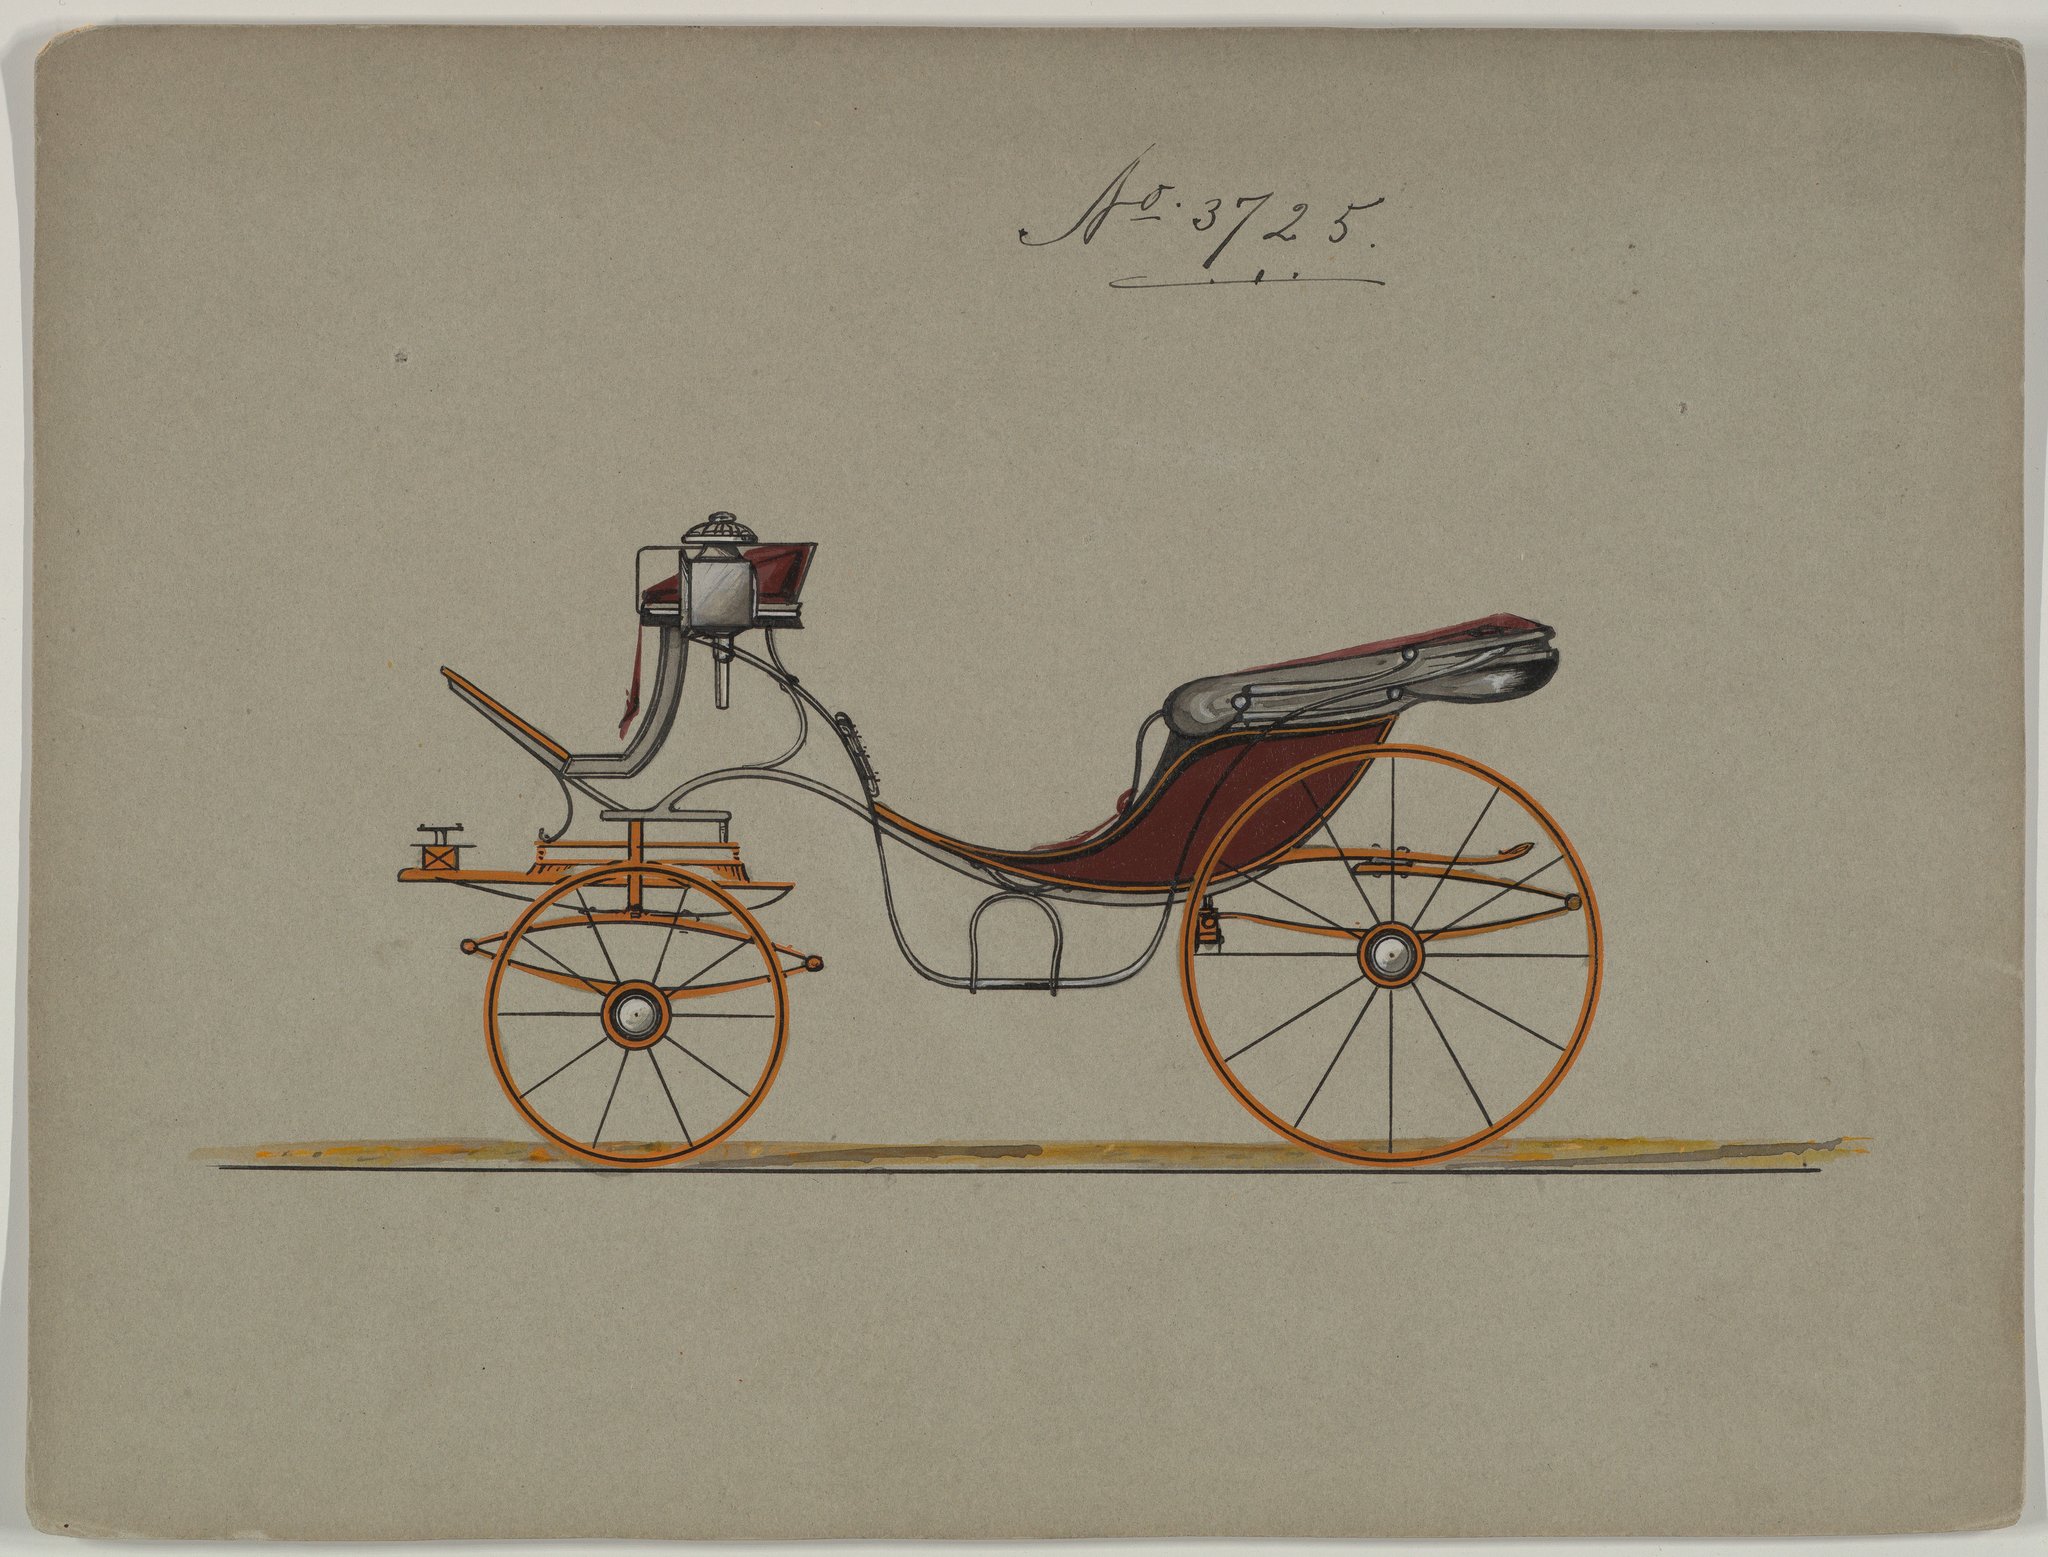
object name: drawing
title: Design for Cabriolet or Victoria, no. 3725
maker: brewster & co.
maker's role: manufacturer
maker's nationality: american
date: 1850-1910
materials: gouache, gum arabic, ink, watercolor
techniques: pen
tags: carriages